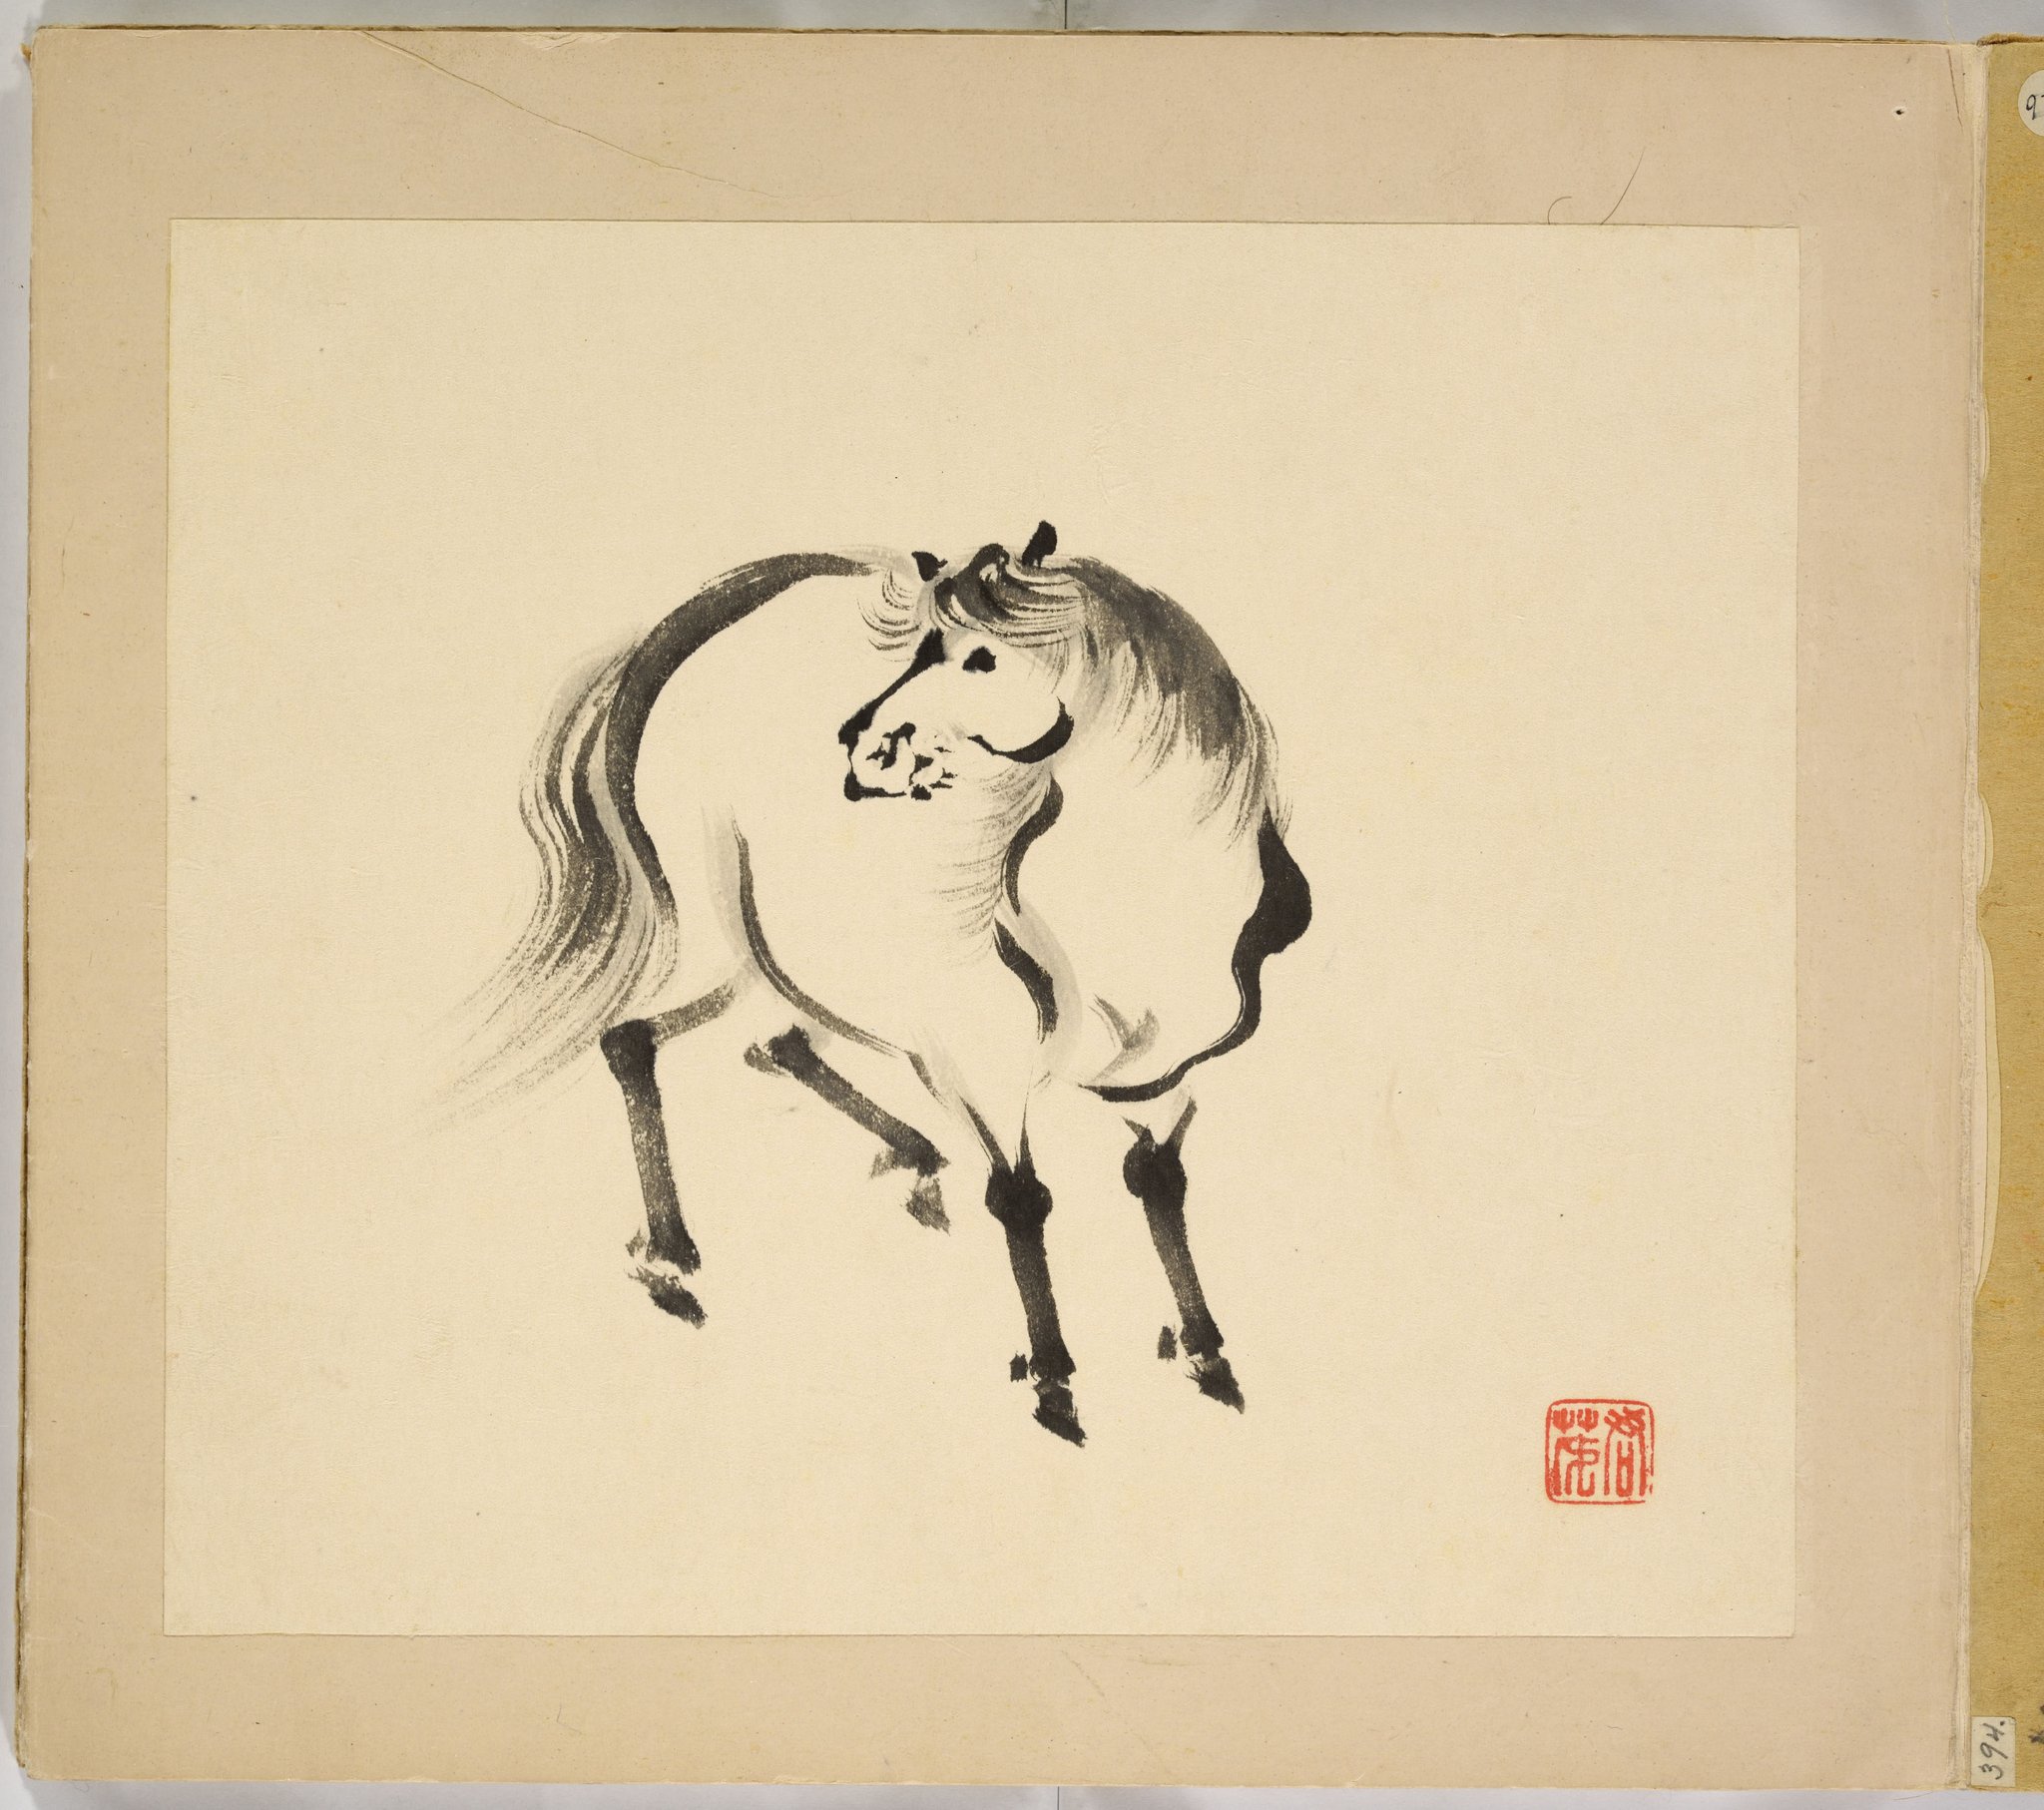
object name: illustrated book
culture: japanese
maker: tsurusawa tansaku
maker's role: artist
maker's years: 1797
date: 1701-1800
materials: ink, paper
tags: horses